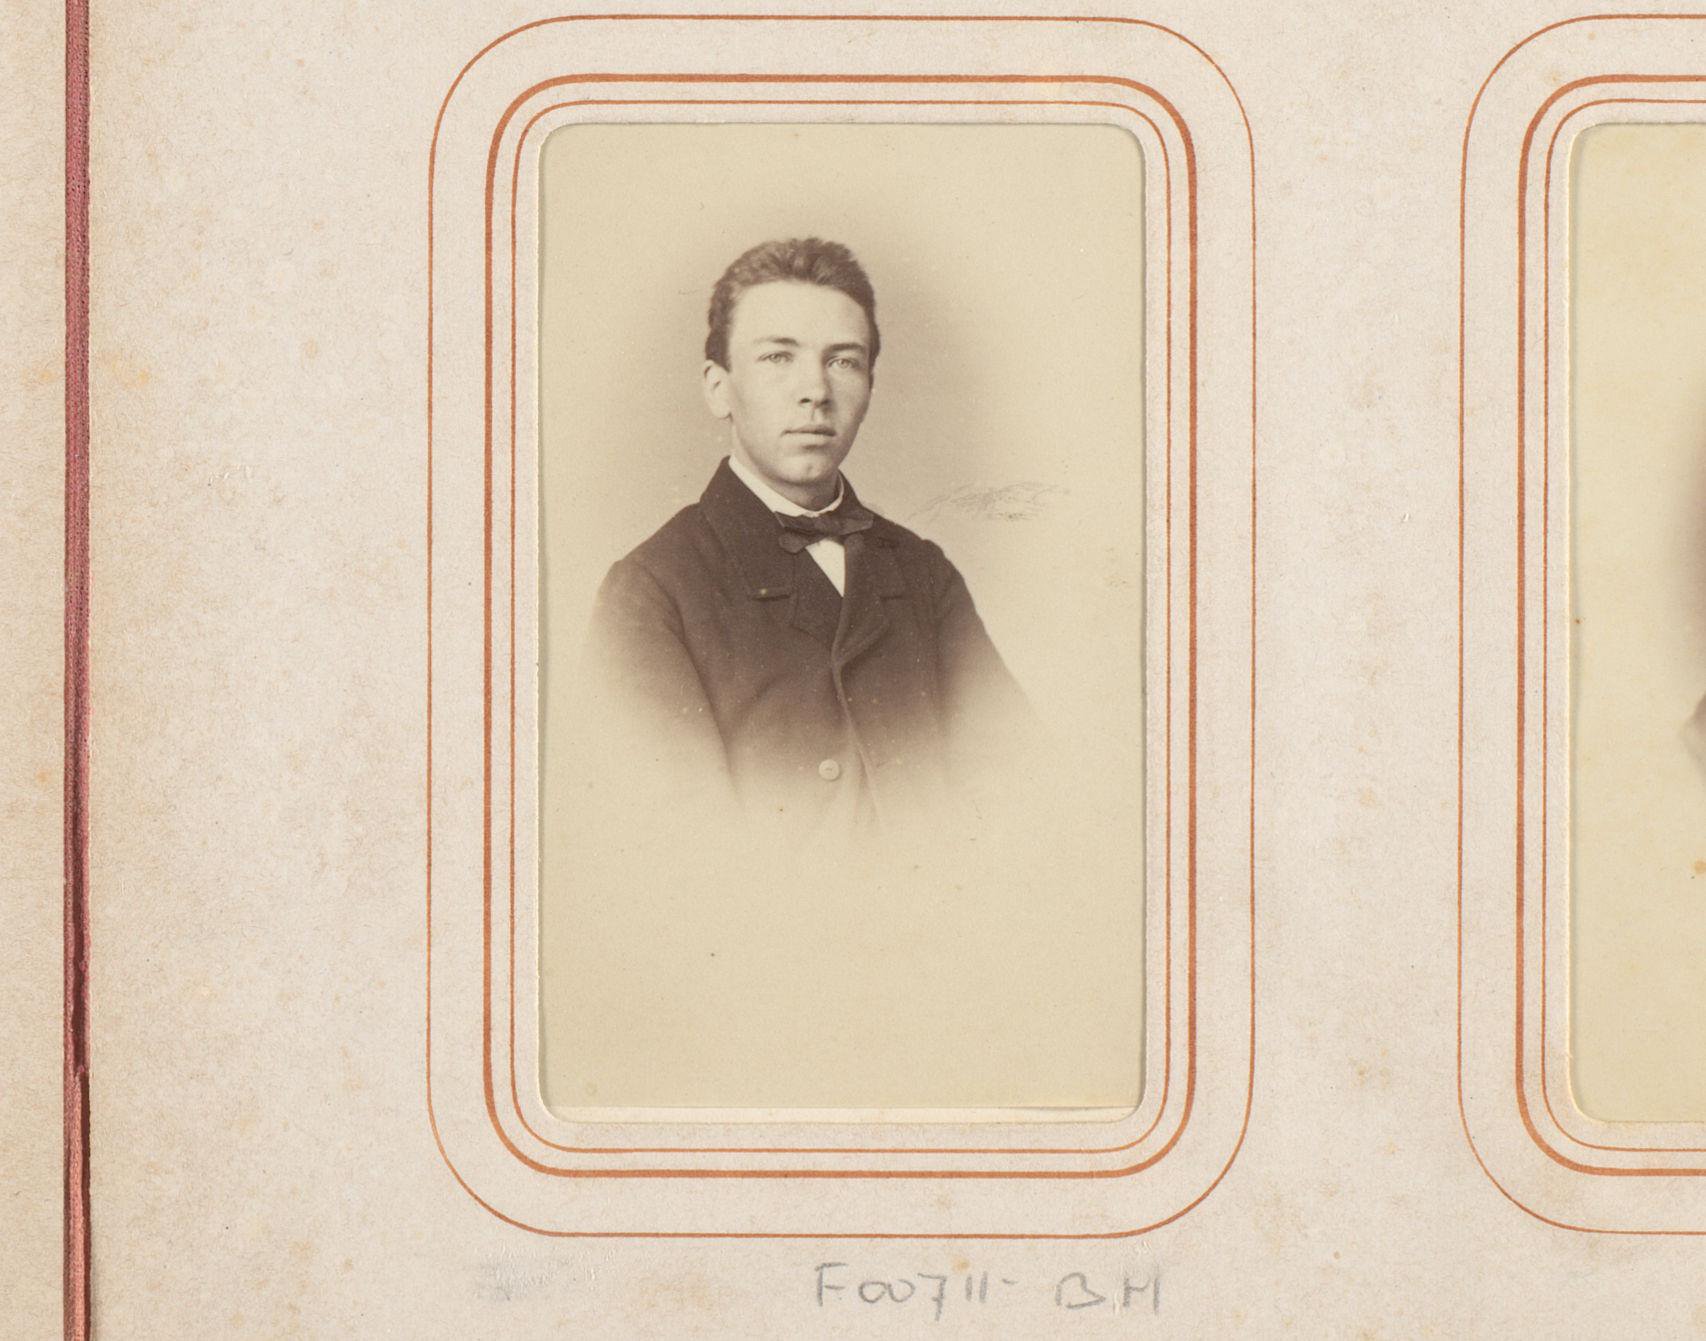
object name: album leaf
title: Portret van een jongeman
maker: françois hermans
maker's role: fotograaf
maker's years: 1842-1926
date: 1857-1869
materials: cardboard, photographic support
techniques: albumen print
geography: rotterdam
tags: youth, adolescent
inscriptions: inscription: ‘François Hermans/ 421 Hang/ Rotterdam’